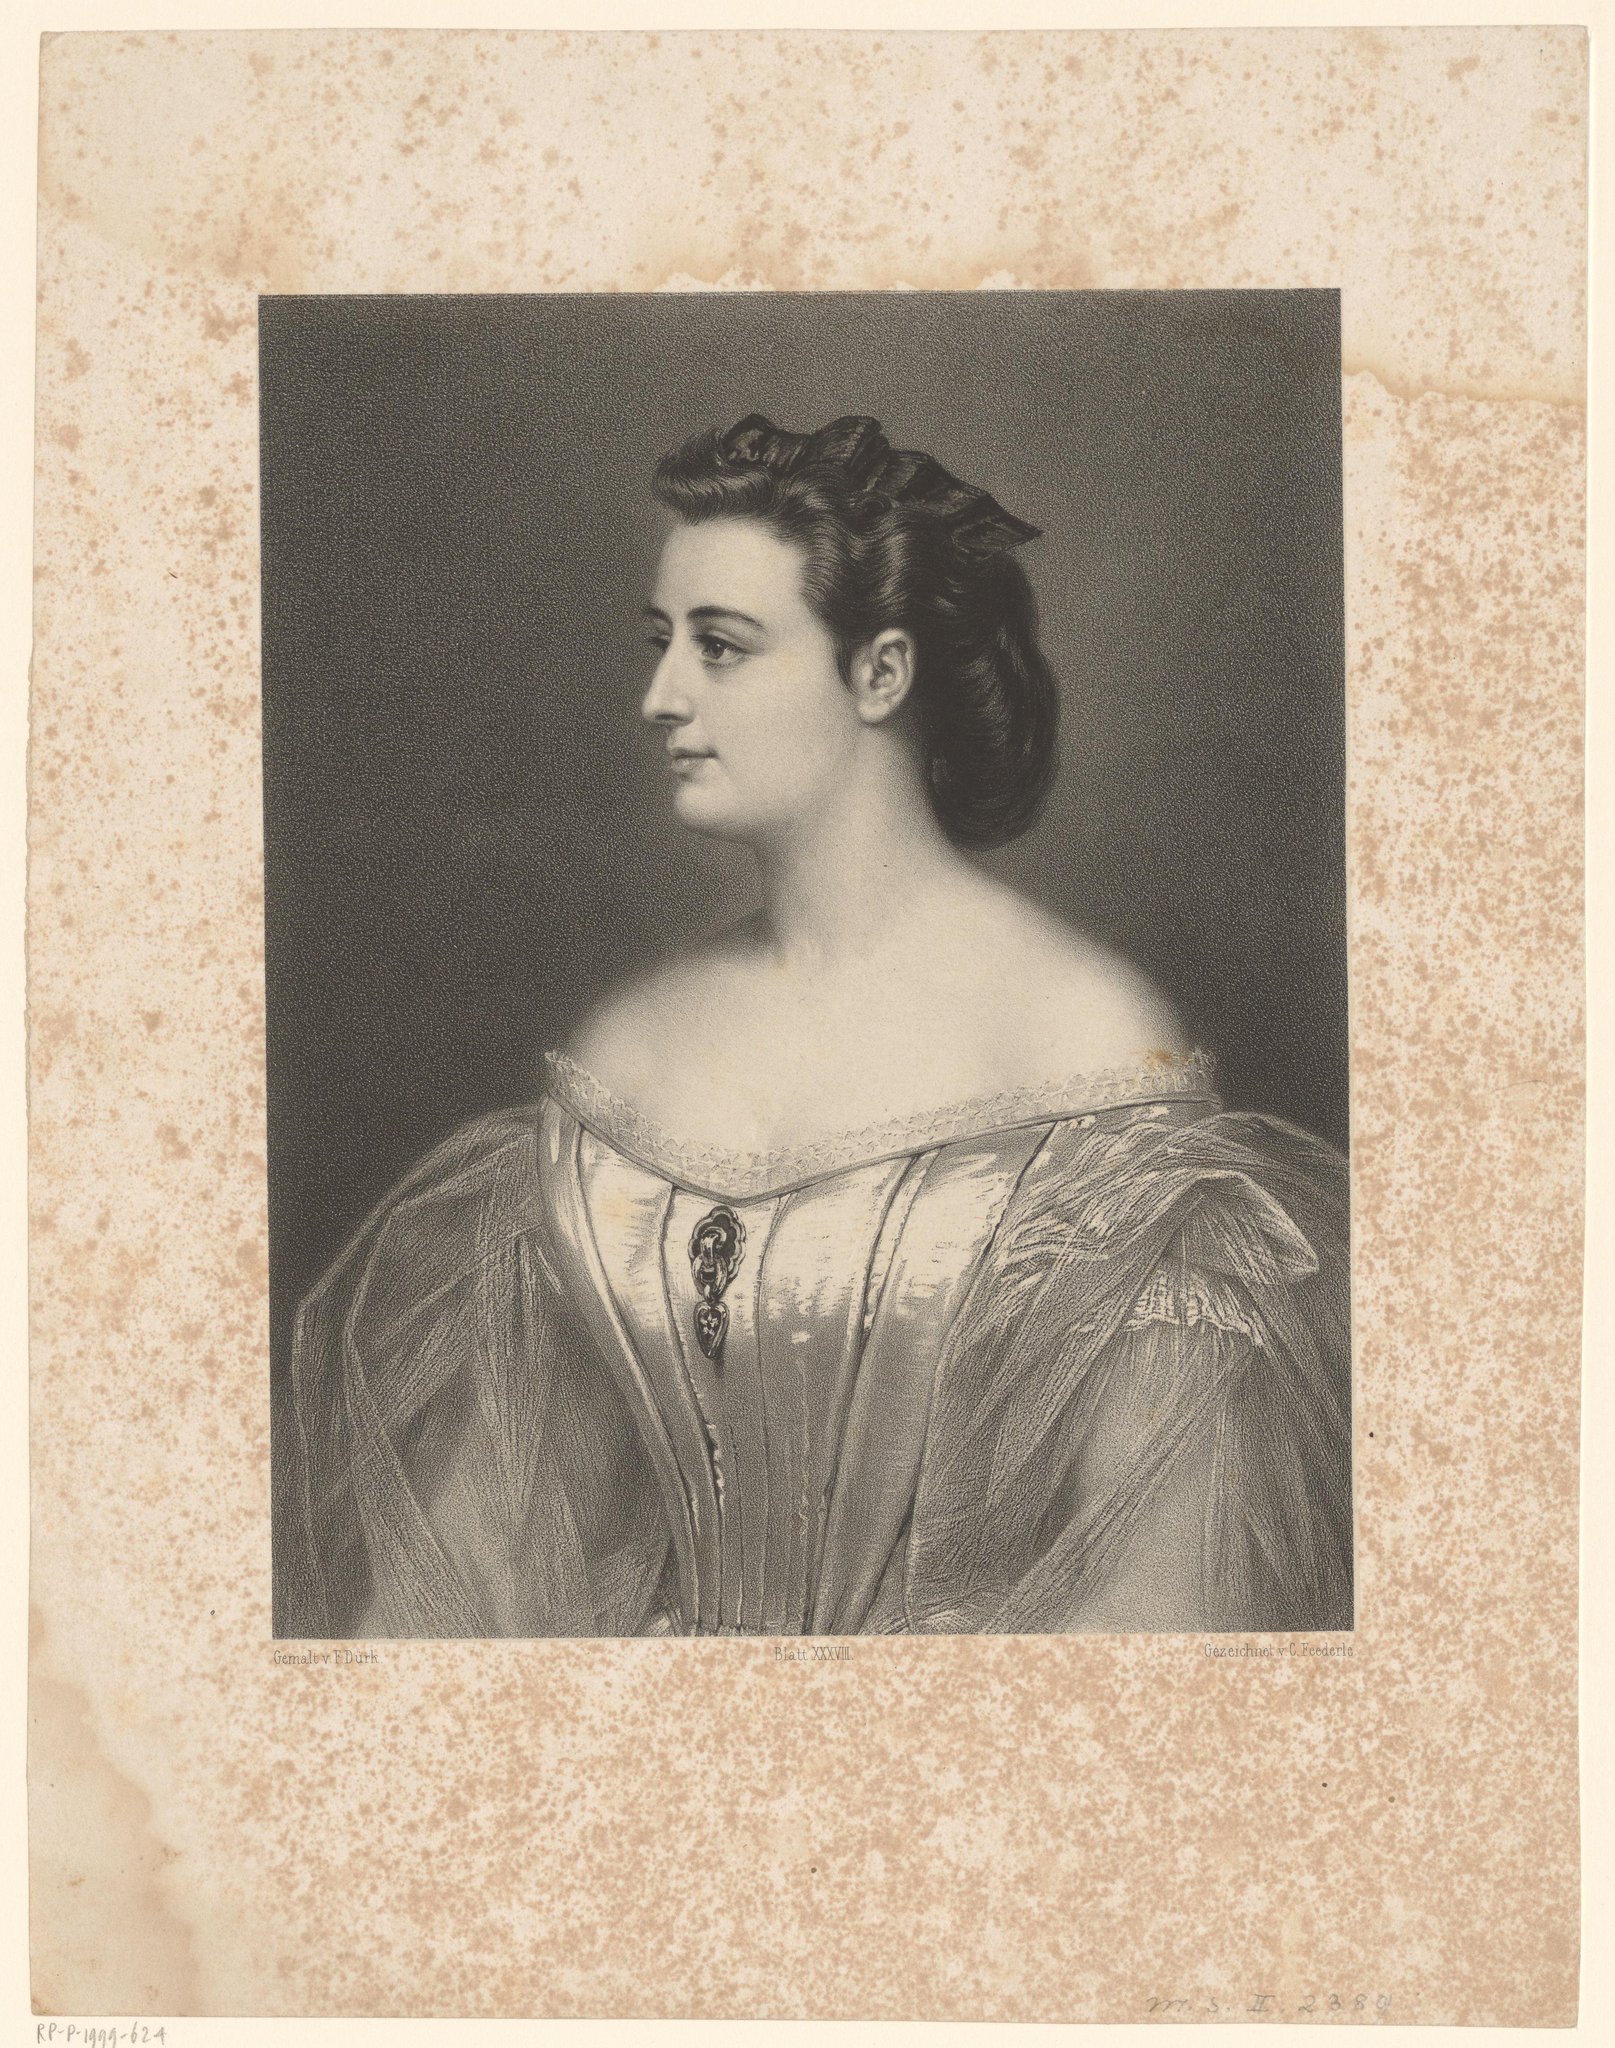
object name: print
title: Galerie van schoonheden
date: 1860-1881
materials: paper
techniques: lithograph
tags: historical persons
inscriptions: collector's mark: Lugt 2228, collector's mark: Lugt 4100, number: ‘Blatt XXXVIII’, collector's mark: Lugt 2760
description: Prent naar het schilderij uit de Schönheitengalerie op Slot Nymphenburg te München, geschilderd in opdracht van koning Lodewijk I van Beieren.